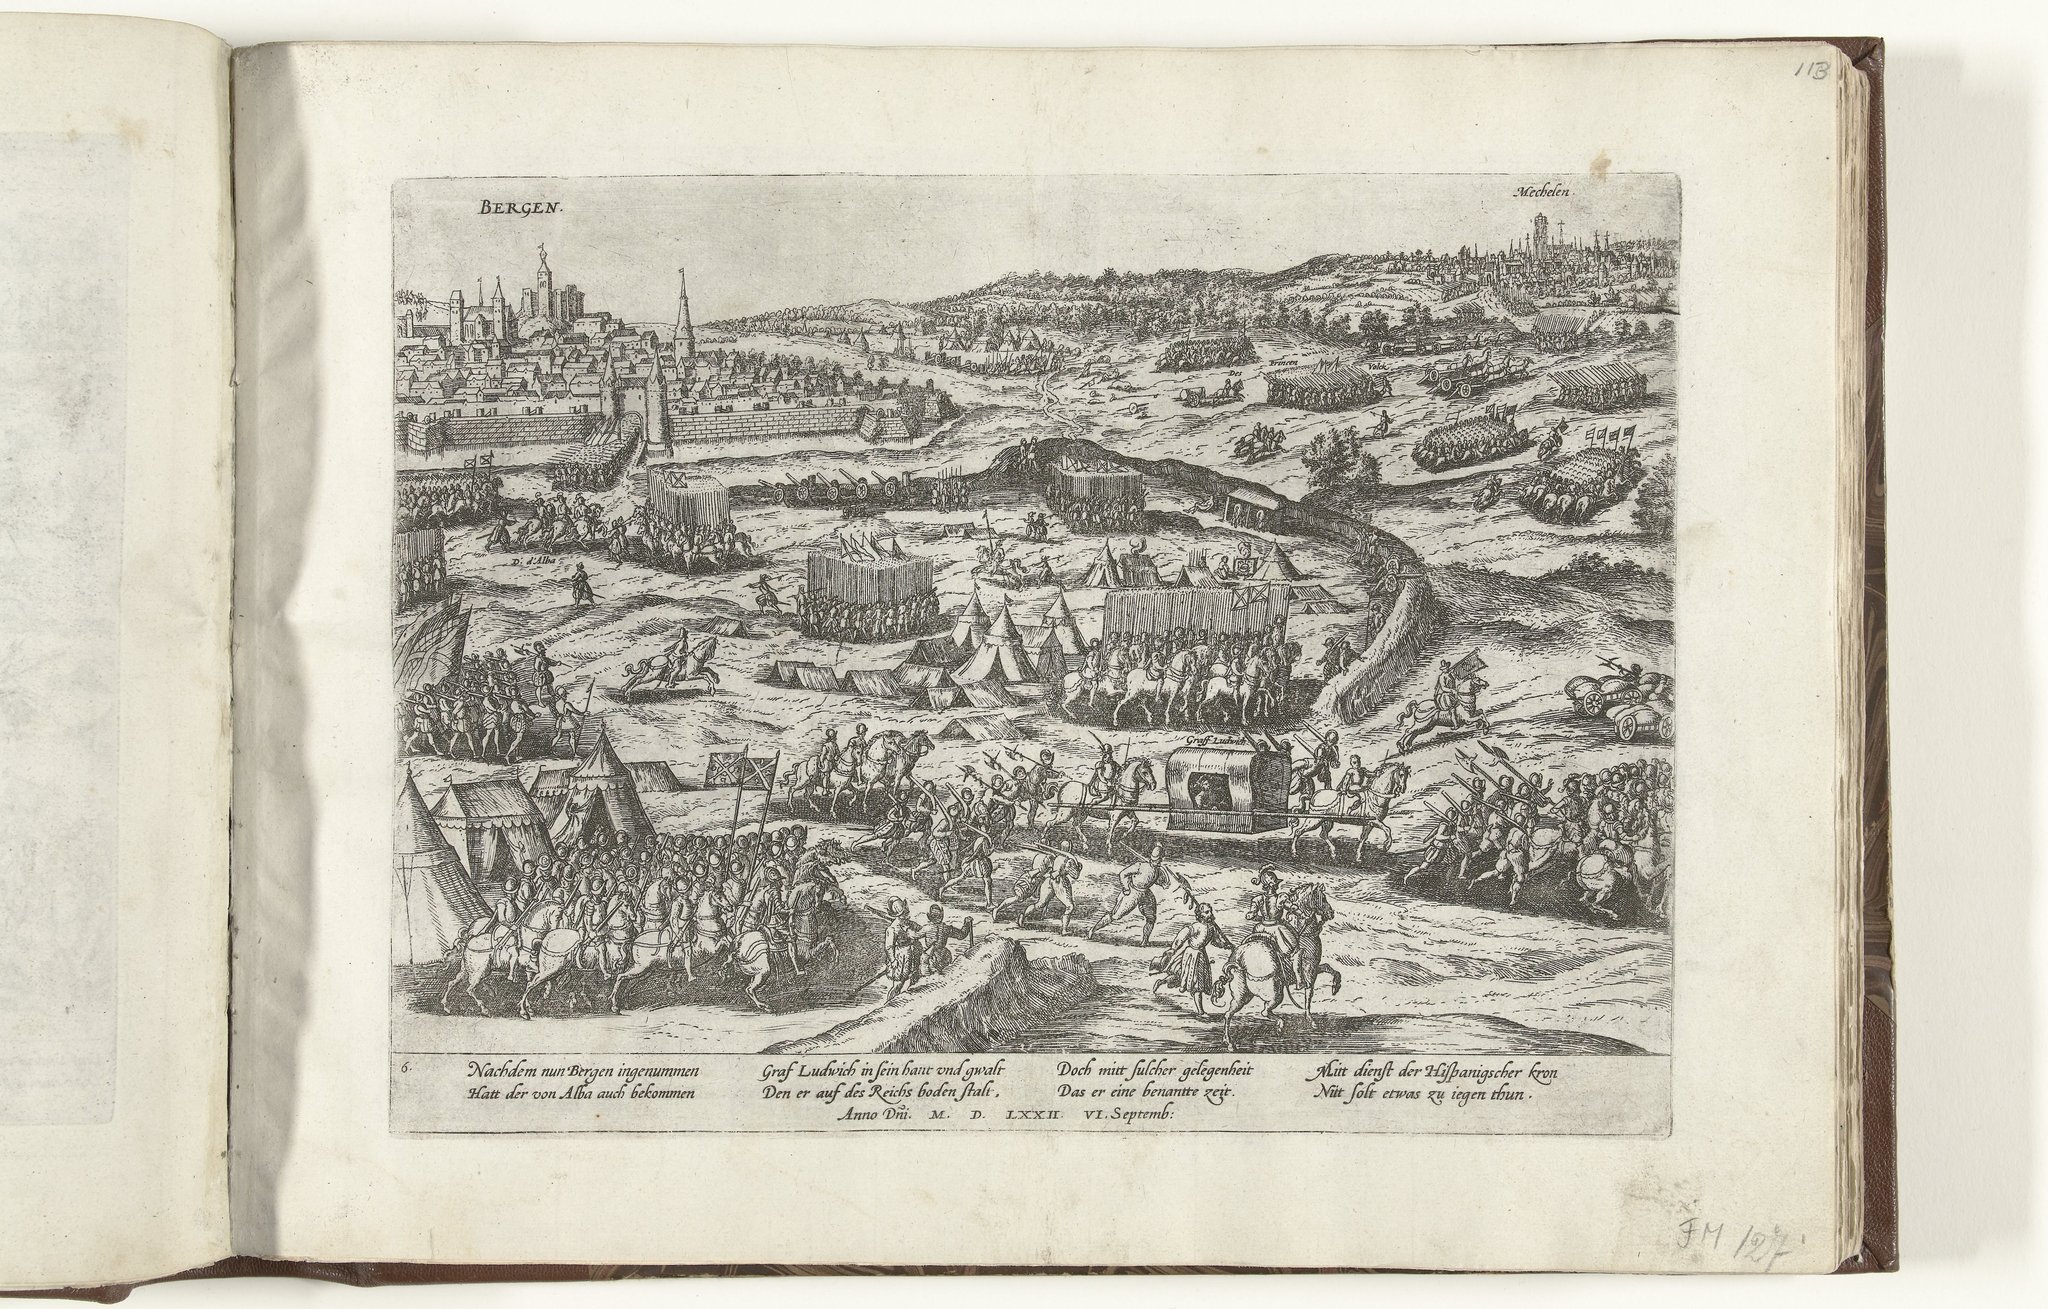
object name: print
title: Lodewijk van Nassau verlaat Bergen, 1572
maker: frans hogenberg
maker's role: print maker, publisher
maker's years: 1538-1590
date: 1572-1574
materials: paper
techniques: etching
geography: cologne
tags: fernando álvarez de toledo (3rd duke of alba), capture of city (after the siege), mechelen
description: Het leger van Lodewijk van Nassau verlaat Bergen, 6 september 1572. Links in de verte neemt het leger van Alva de stad weer in, rechts in de verte Mechelen. Op de voorgrond Lodewijk in een draagstoel. Met onderschrift van 8 regels in het Duits. Genummerd: 6.